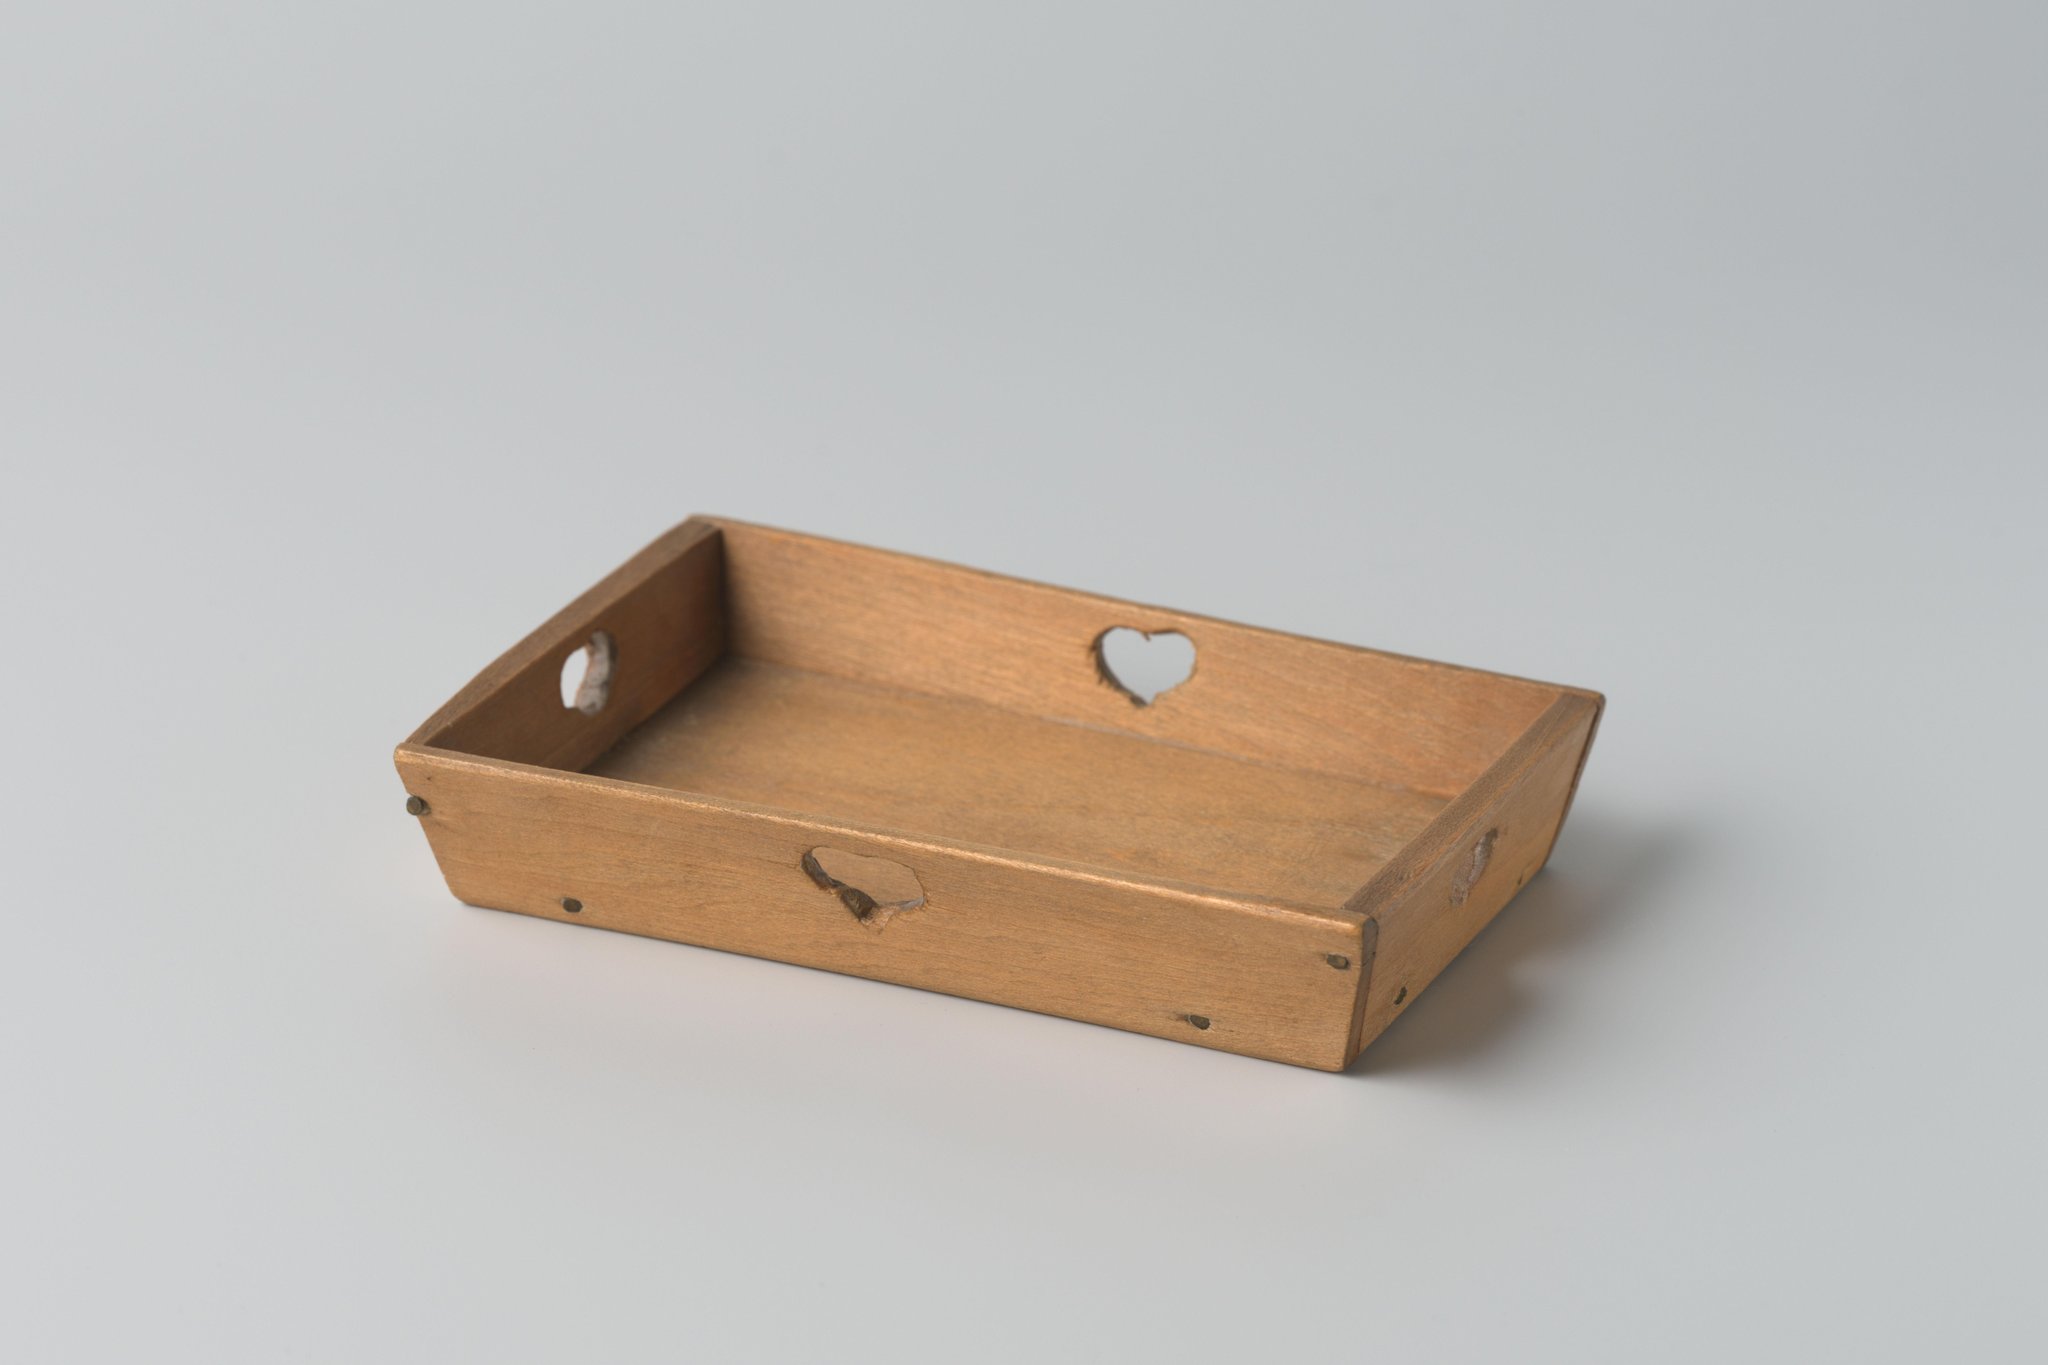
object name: kleerbak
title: Kleerbak van without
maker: Anonymous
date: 1676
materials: without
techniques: without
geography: amsterdam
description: Kleerbak van without met vier schuinopstaande wanden, waarin een hartvormige handgreep is uitgezaagd. In elkaar gespijkerd.